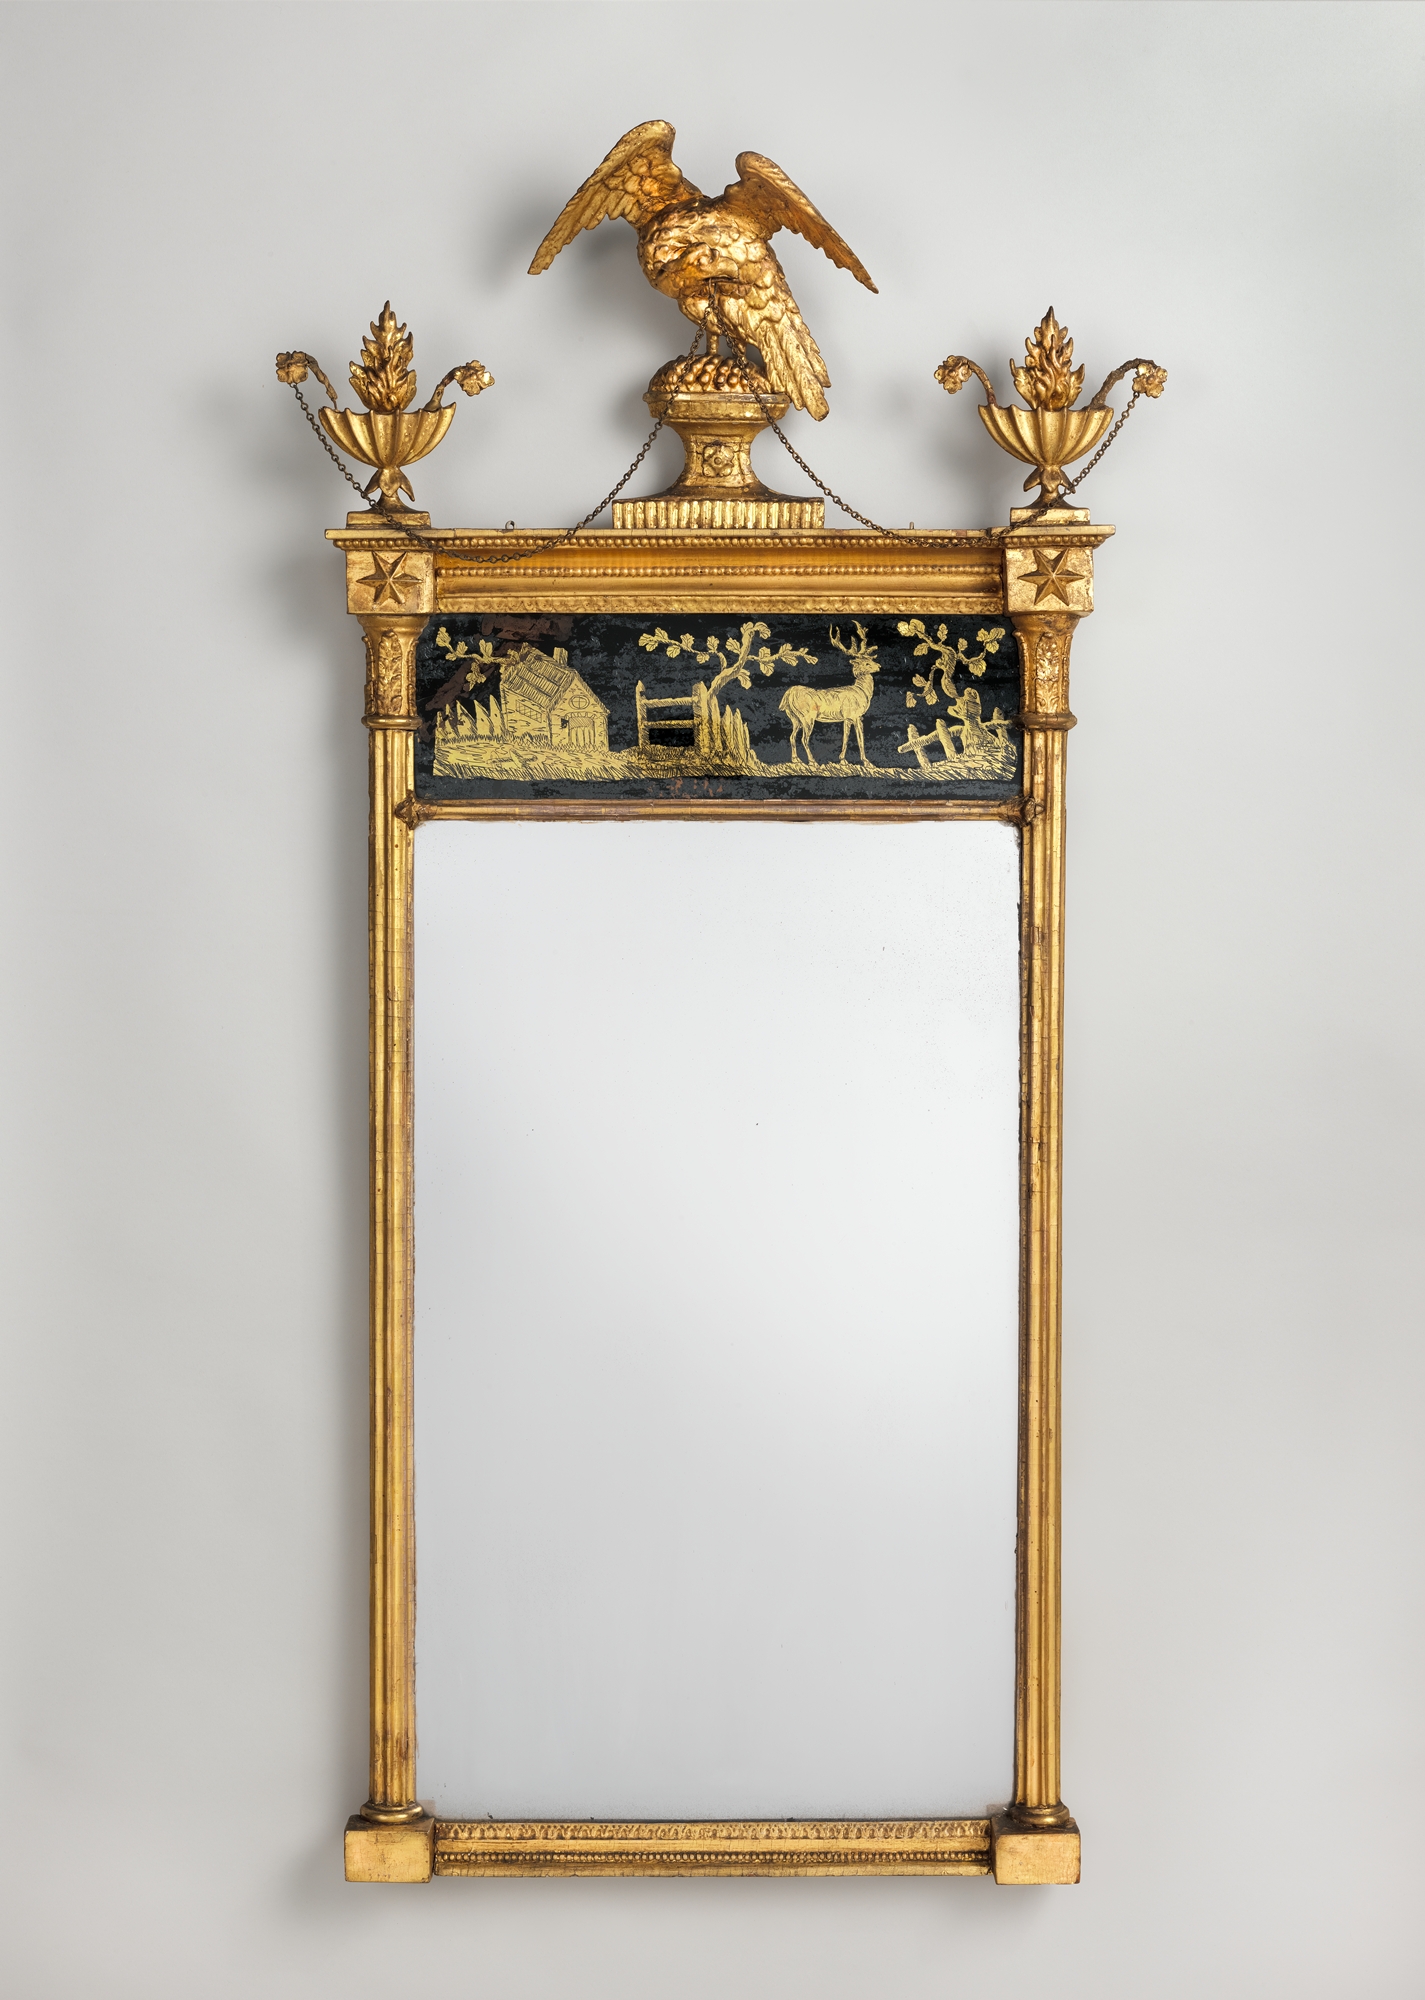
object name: looking glass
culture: american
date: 1800-1820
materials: gesso, gilt, wood, metal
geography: united states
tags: eagles,deer